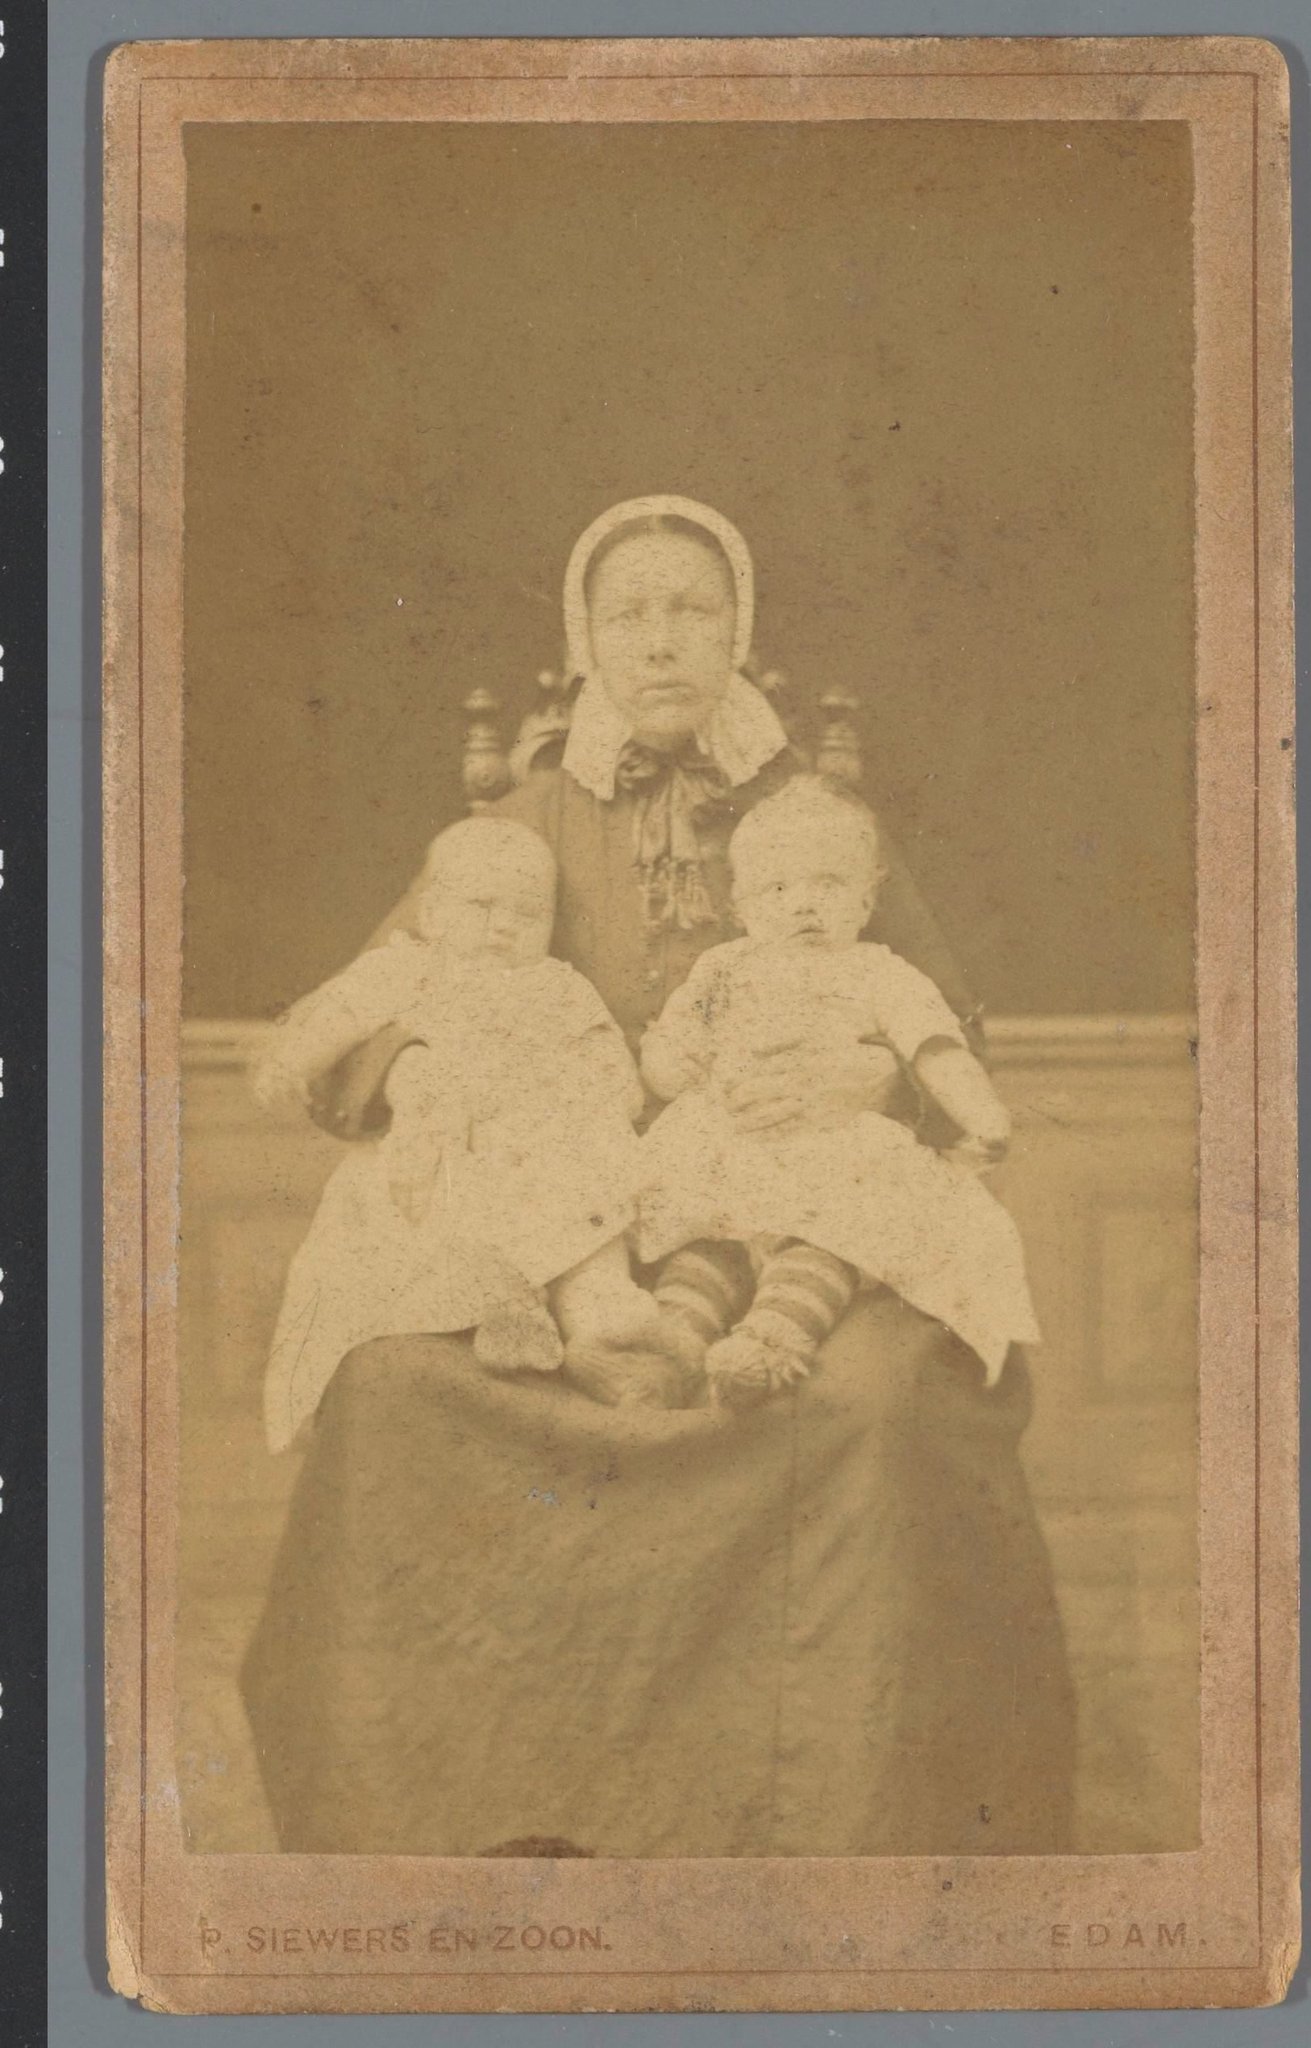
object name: photograph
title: Portret van een onbekende vrouw met twee baby's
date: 1877-1886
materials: cardboard, paper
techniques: albumen print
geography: edam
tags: anonymous historical person portrayed, mother and child(ren), woman and child(ren) (family group)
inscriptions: inscription: ‘P. Siewers en Zoon. Edam.’, inscription: ‘P. Siewers en Zoon/ Photogr./ Atelier/ Edam Voorhaven/ Hilversum Badhuis./ Te Edam dagelyks werkzaam./ Te Hilversum Zondags en maandags./ De Plaat wordt voor Nabestelling/ bewaard.’